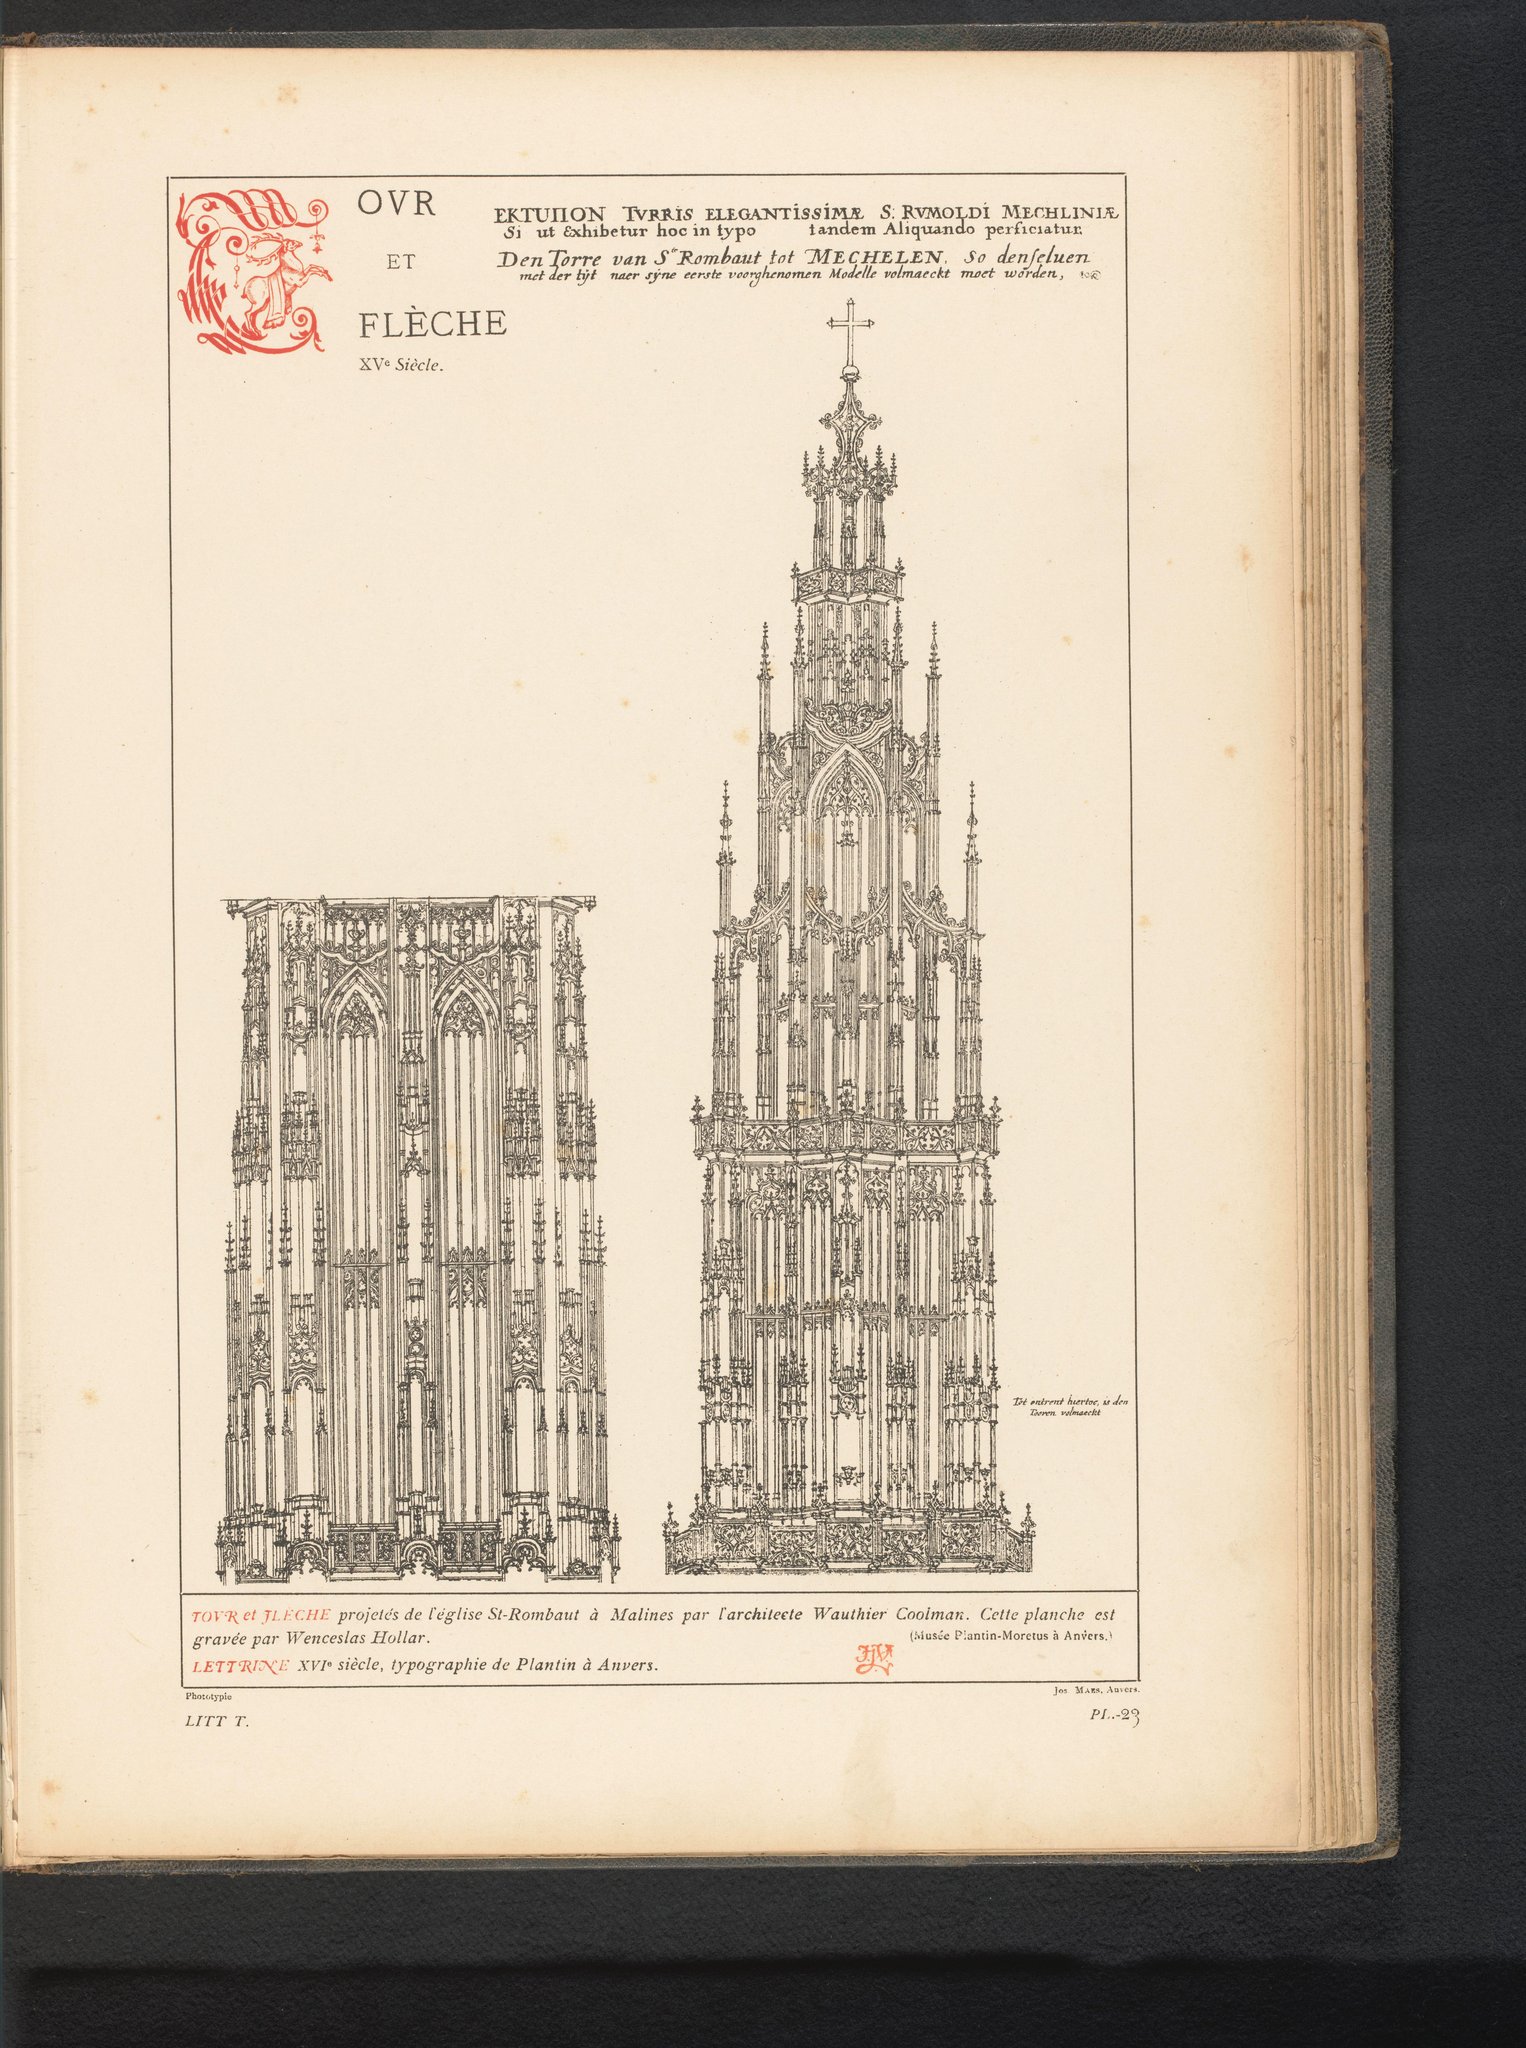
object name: photomechanical print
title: Tour et flèche, XVe Siècle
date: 1876-1881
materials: paper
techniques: photolithography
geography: antwerp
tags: church (exterior)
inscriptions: inscription: ‘LITT. T. - PL. 23.’, inscription: ‘TOUR et FLÈCHE (...)’, monogram: ‘JJvY’